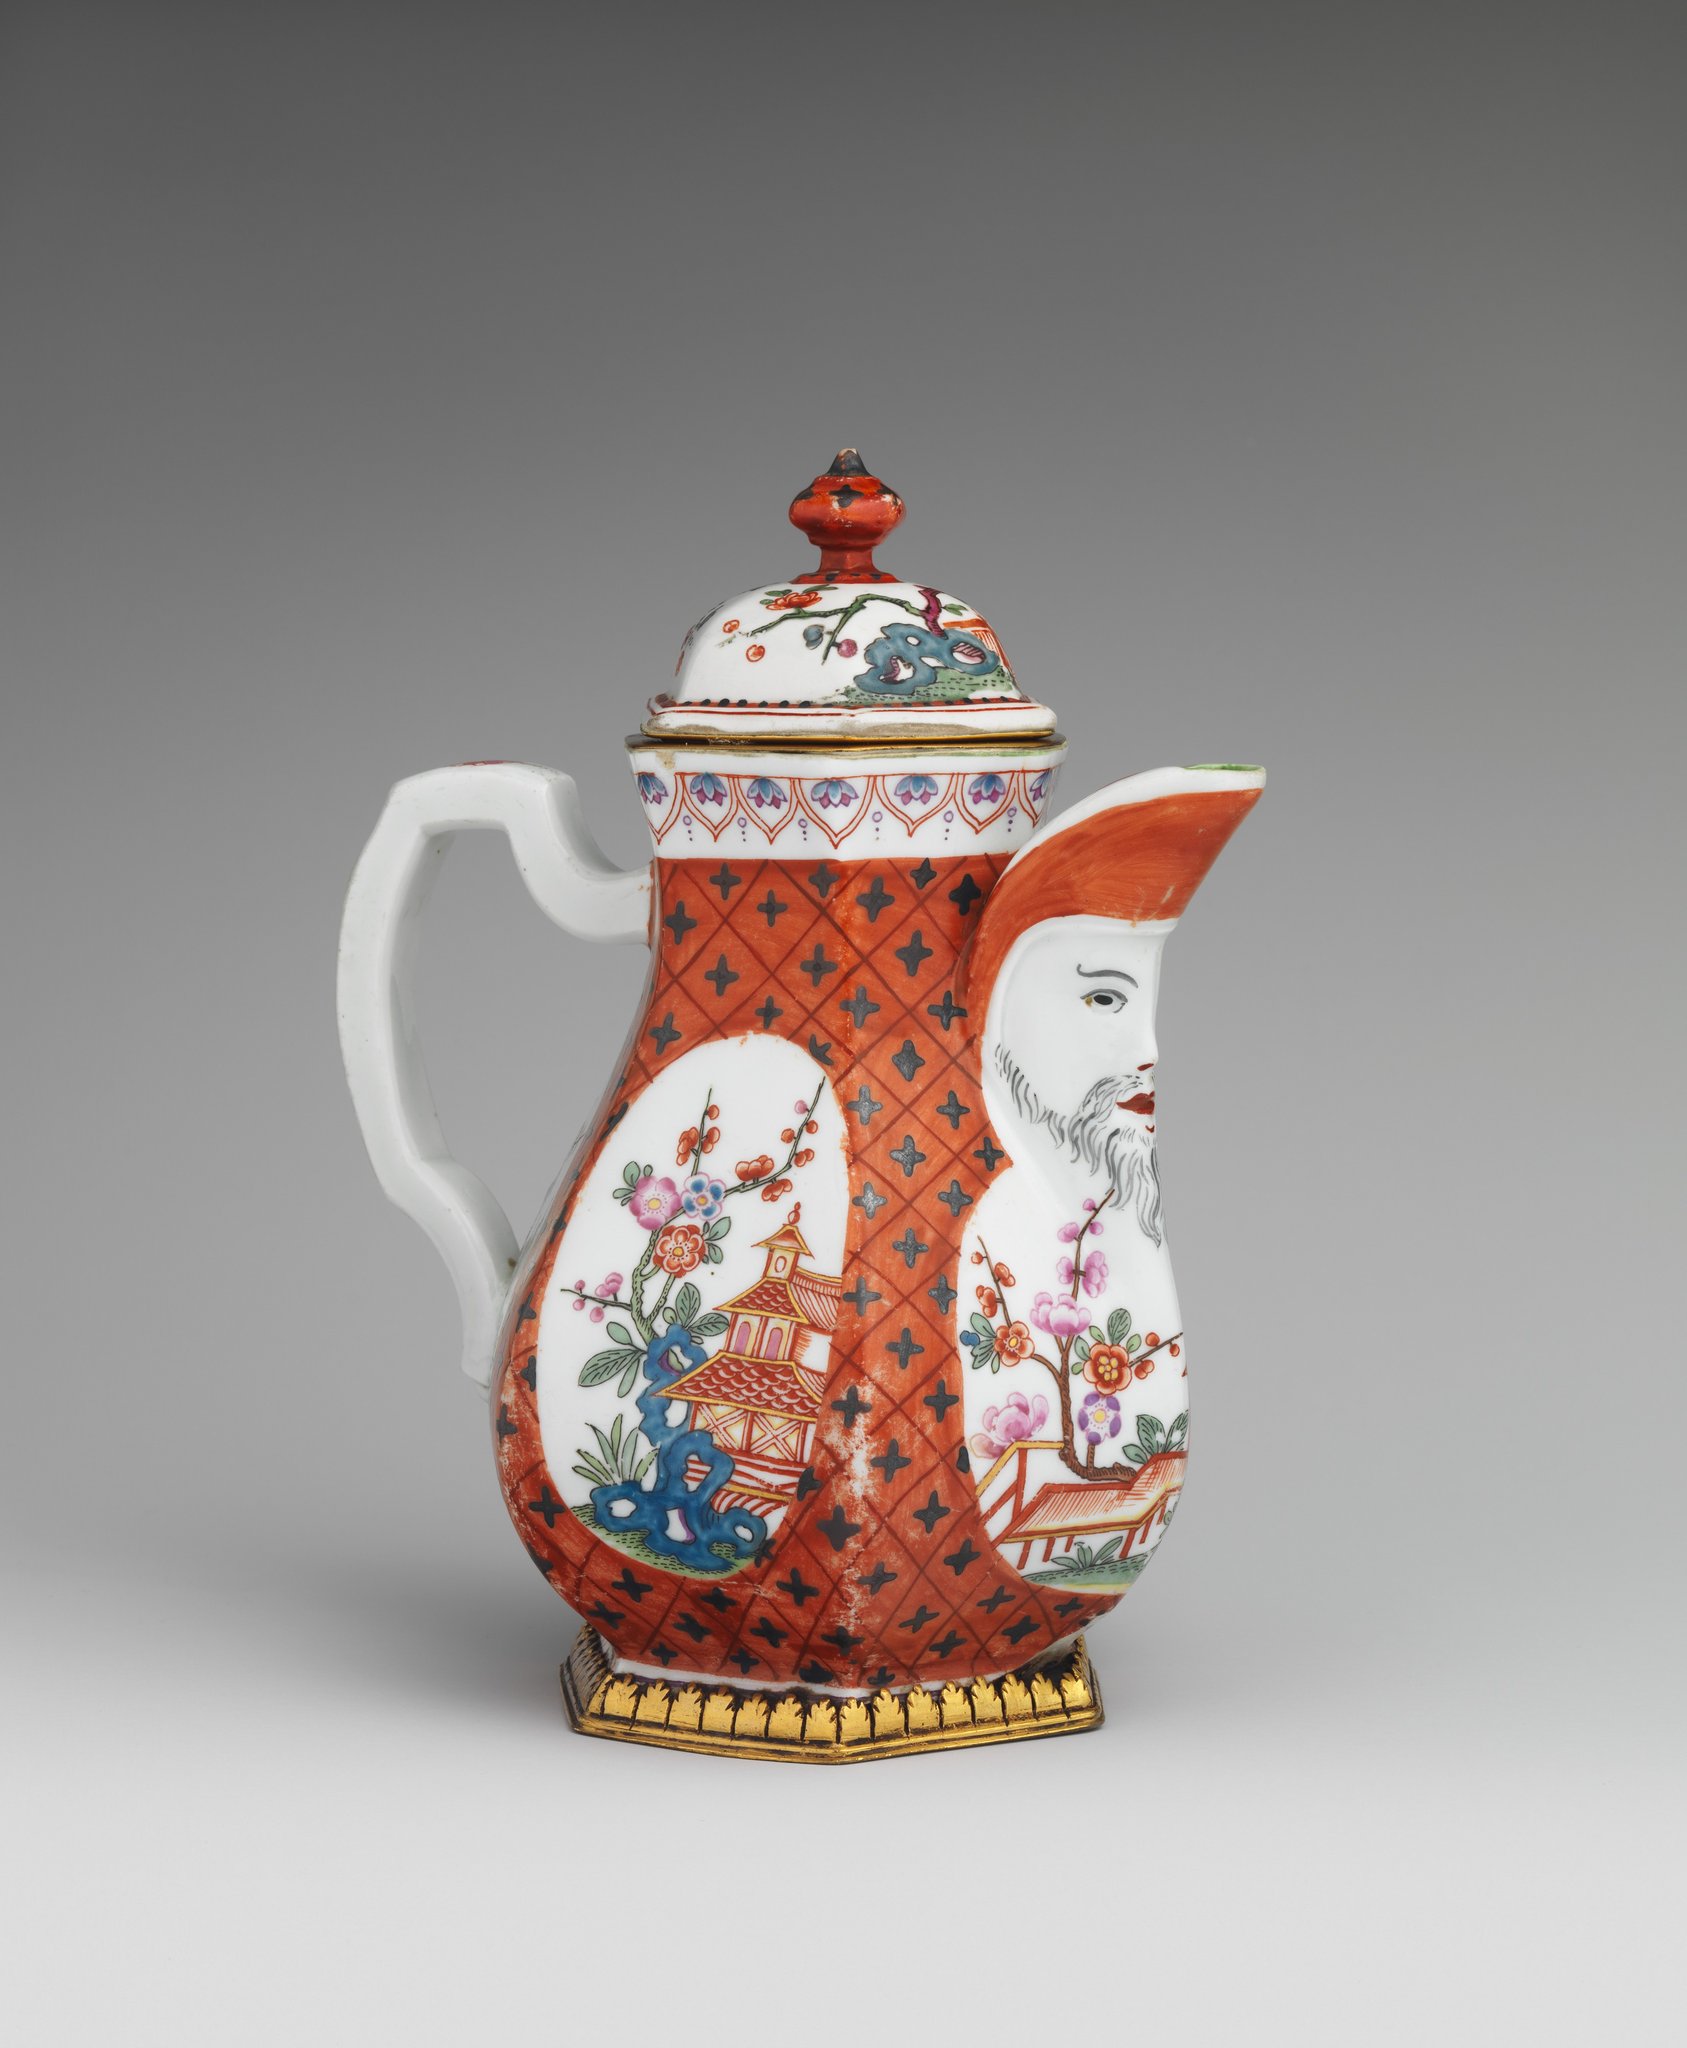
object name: coffeepot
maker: vienna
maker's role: manufactory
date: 1720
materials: hard paste porcelain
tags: houses,faces,flowers